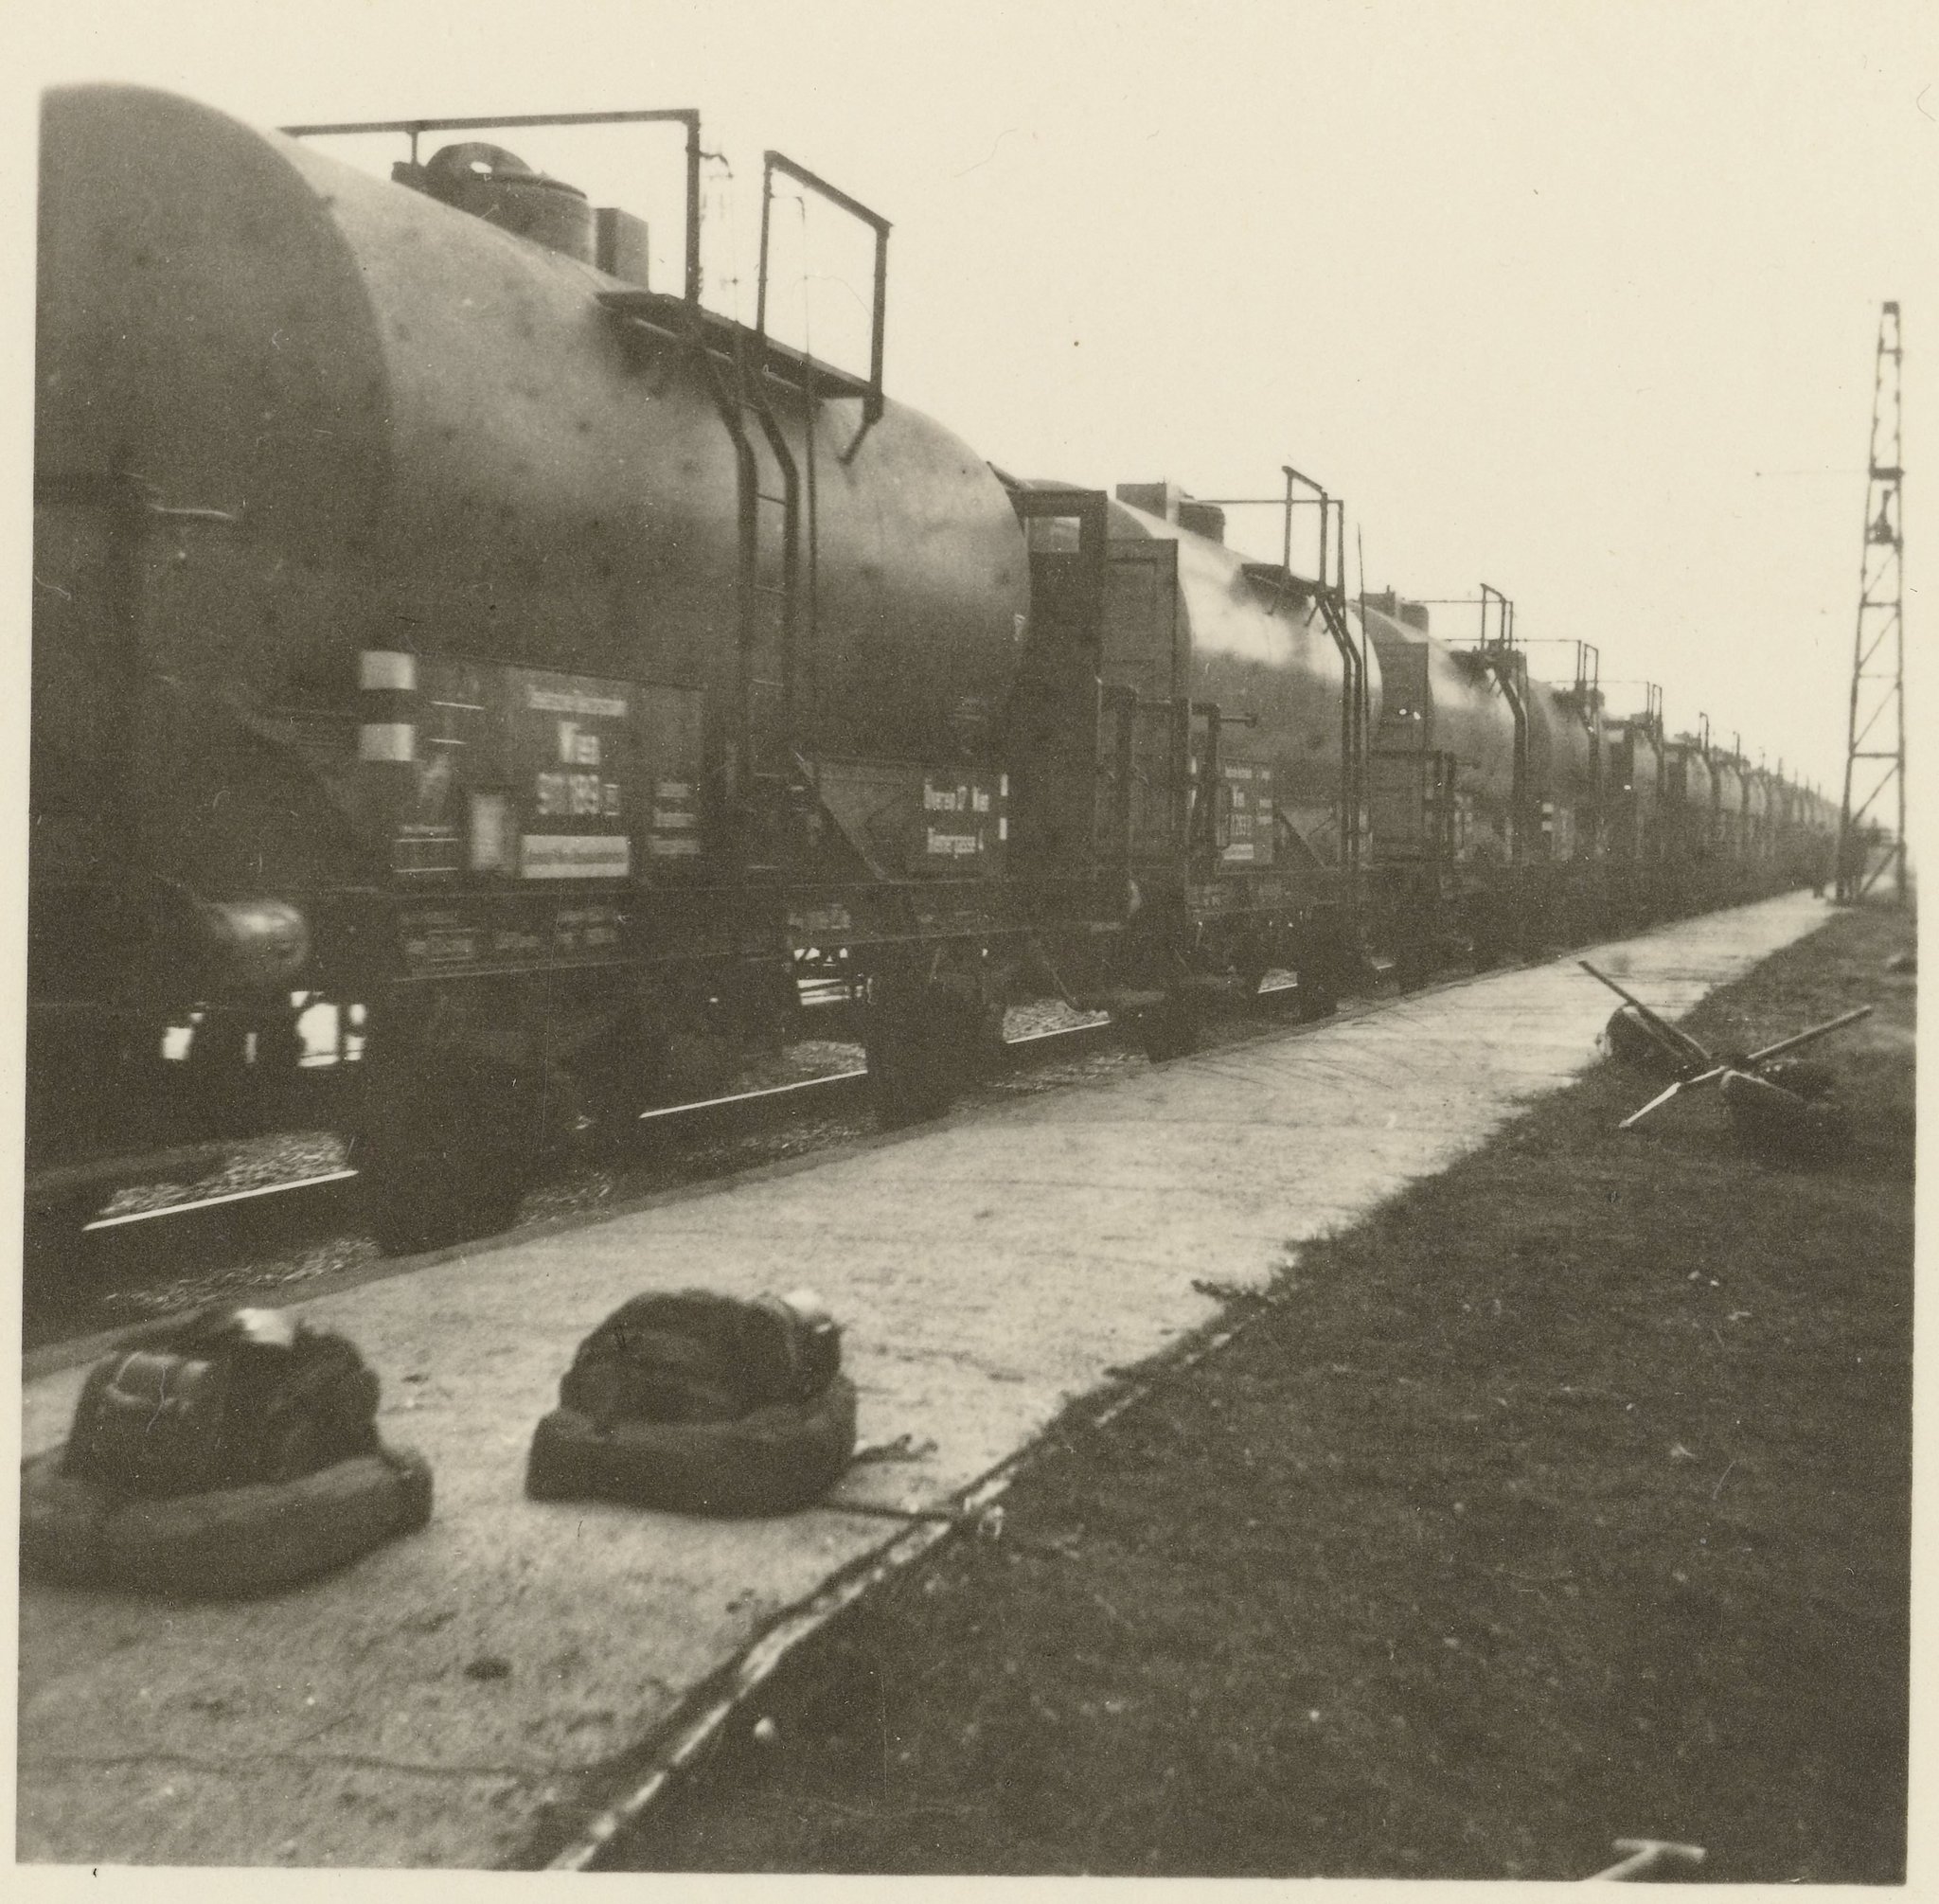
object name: photograph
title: Een stilstaande goederentrein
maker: Anonymous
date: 1940-1945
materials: photographic support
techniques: gelatin silver print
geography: france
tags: netherlands, germany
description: Een stilstaande goederentrein. Op de voorgrond twee rugzakken. Foto behorend bij album 'Kriegserinnerungen'.